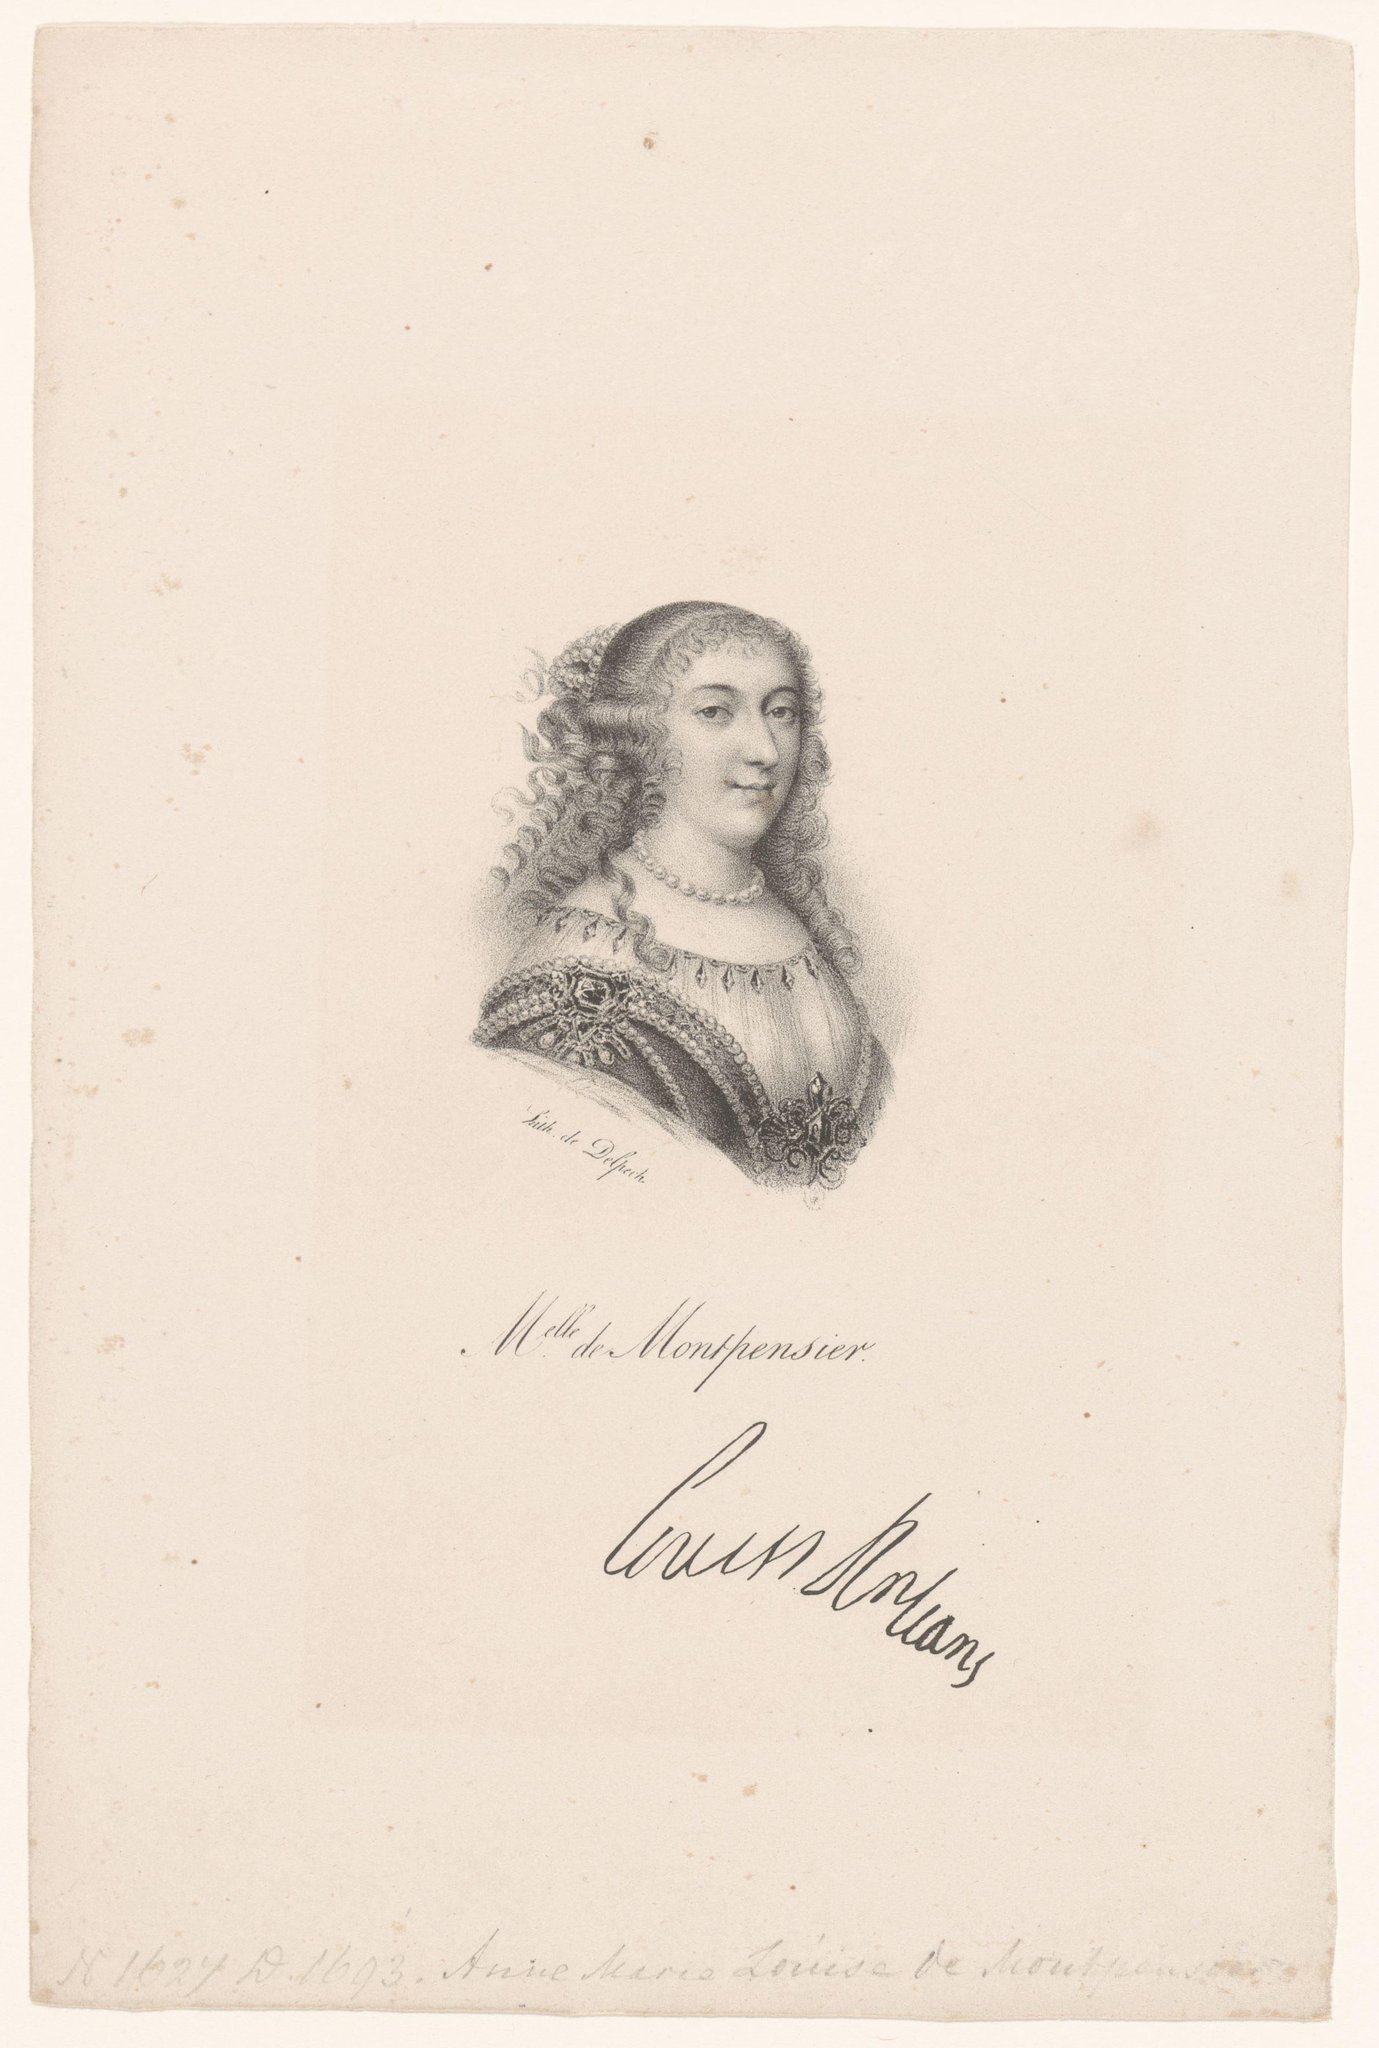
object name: print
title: Portret van Anne-Marie-Louise d'Orléans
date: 1818-1842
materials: paper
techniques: lithograph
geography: paris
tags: paris, anne marie louise d' orléans (hertogin van montpensier), historical persons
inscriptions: collector's mark: Lugt 2228a